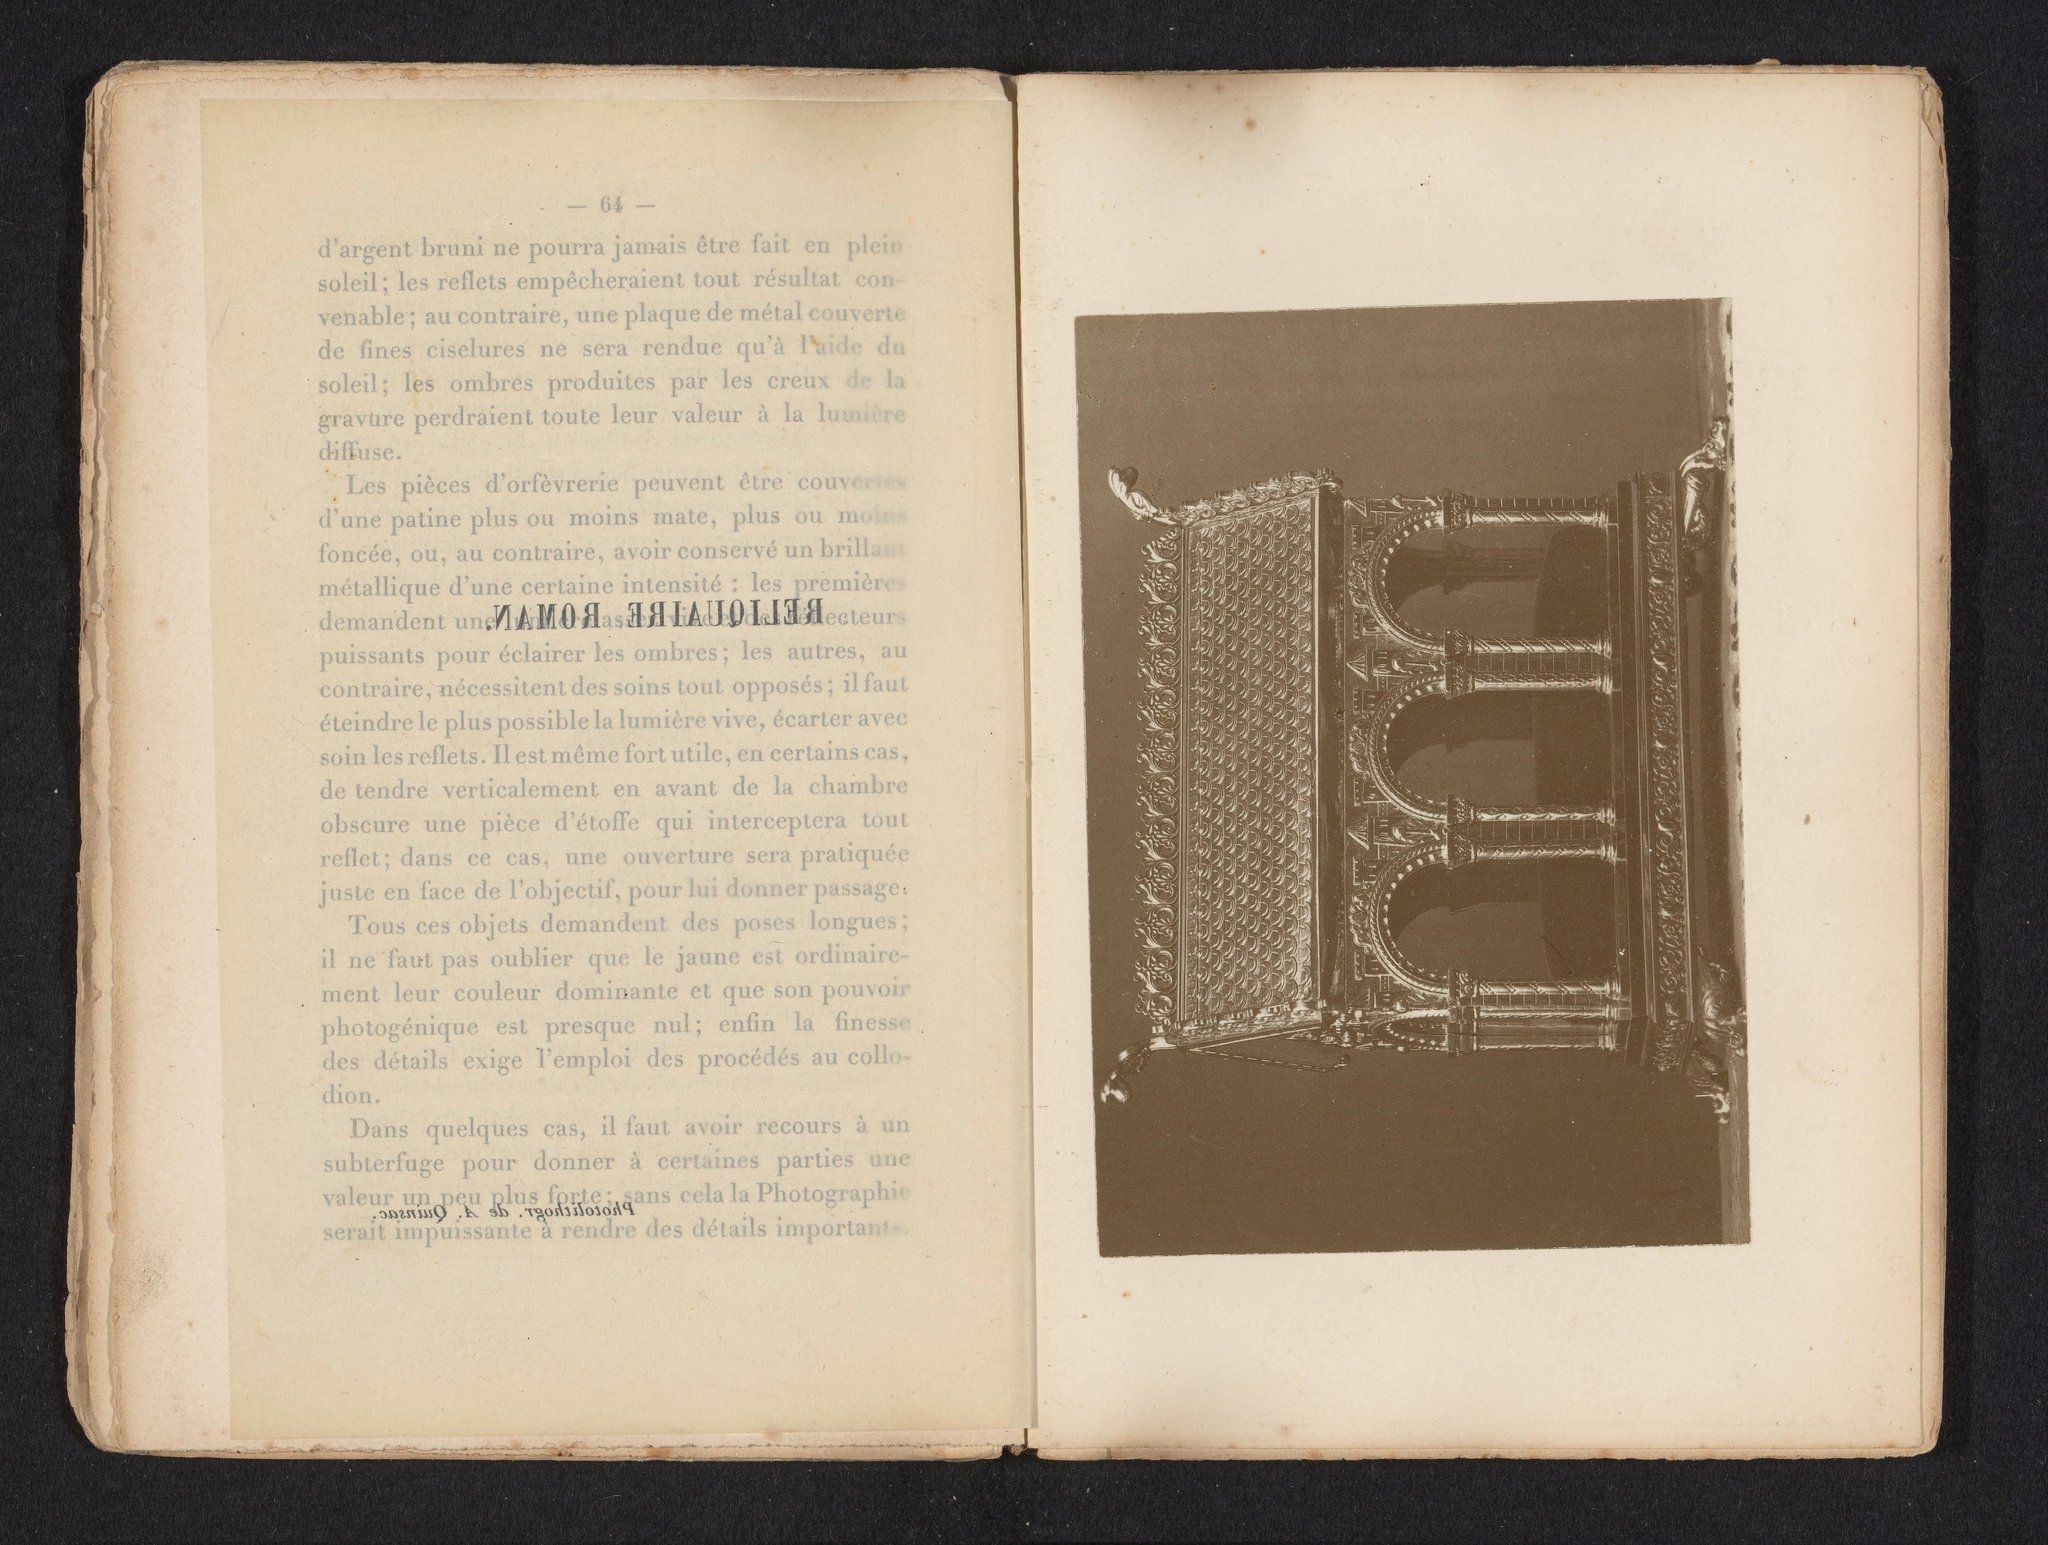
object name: page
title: Reliekschrijn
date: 1869-1879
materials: paper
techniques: photograph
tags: relics (and reliquaries)